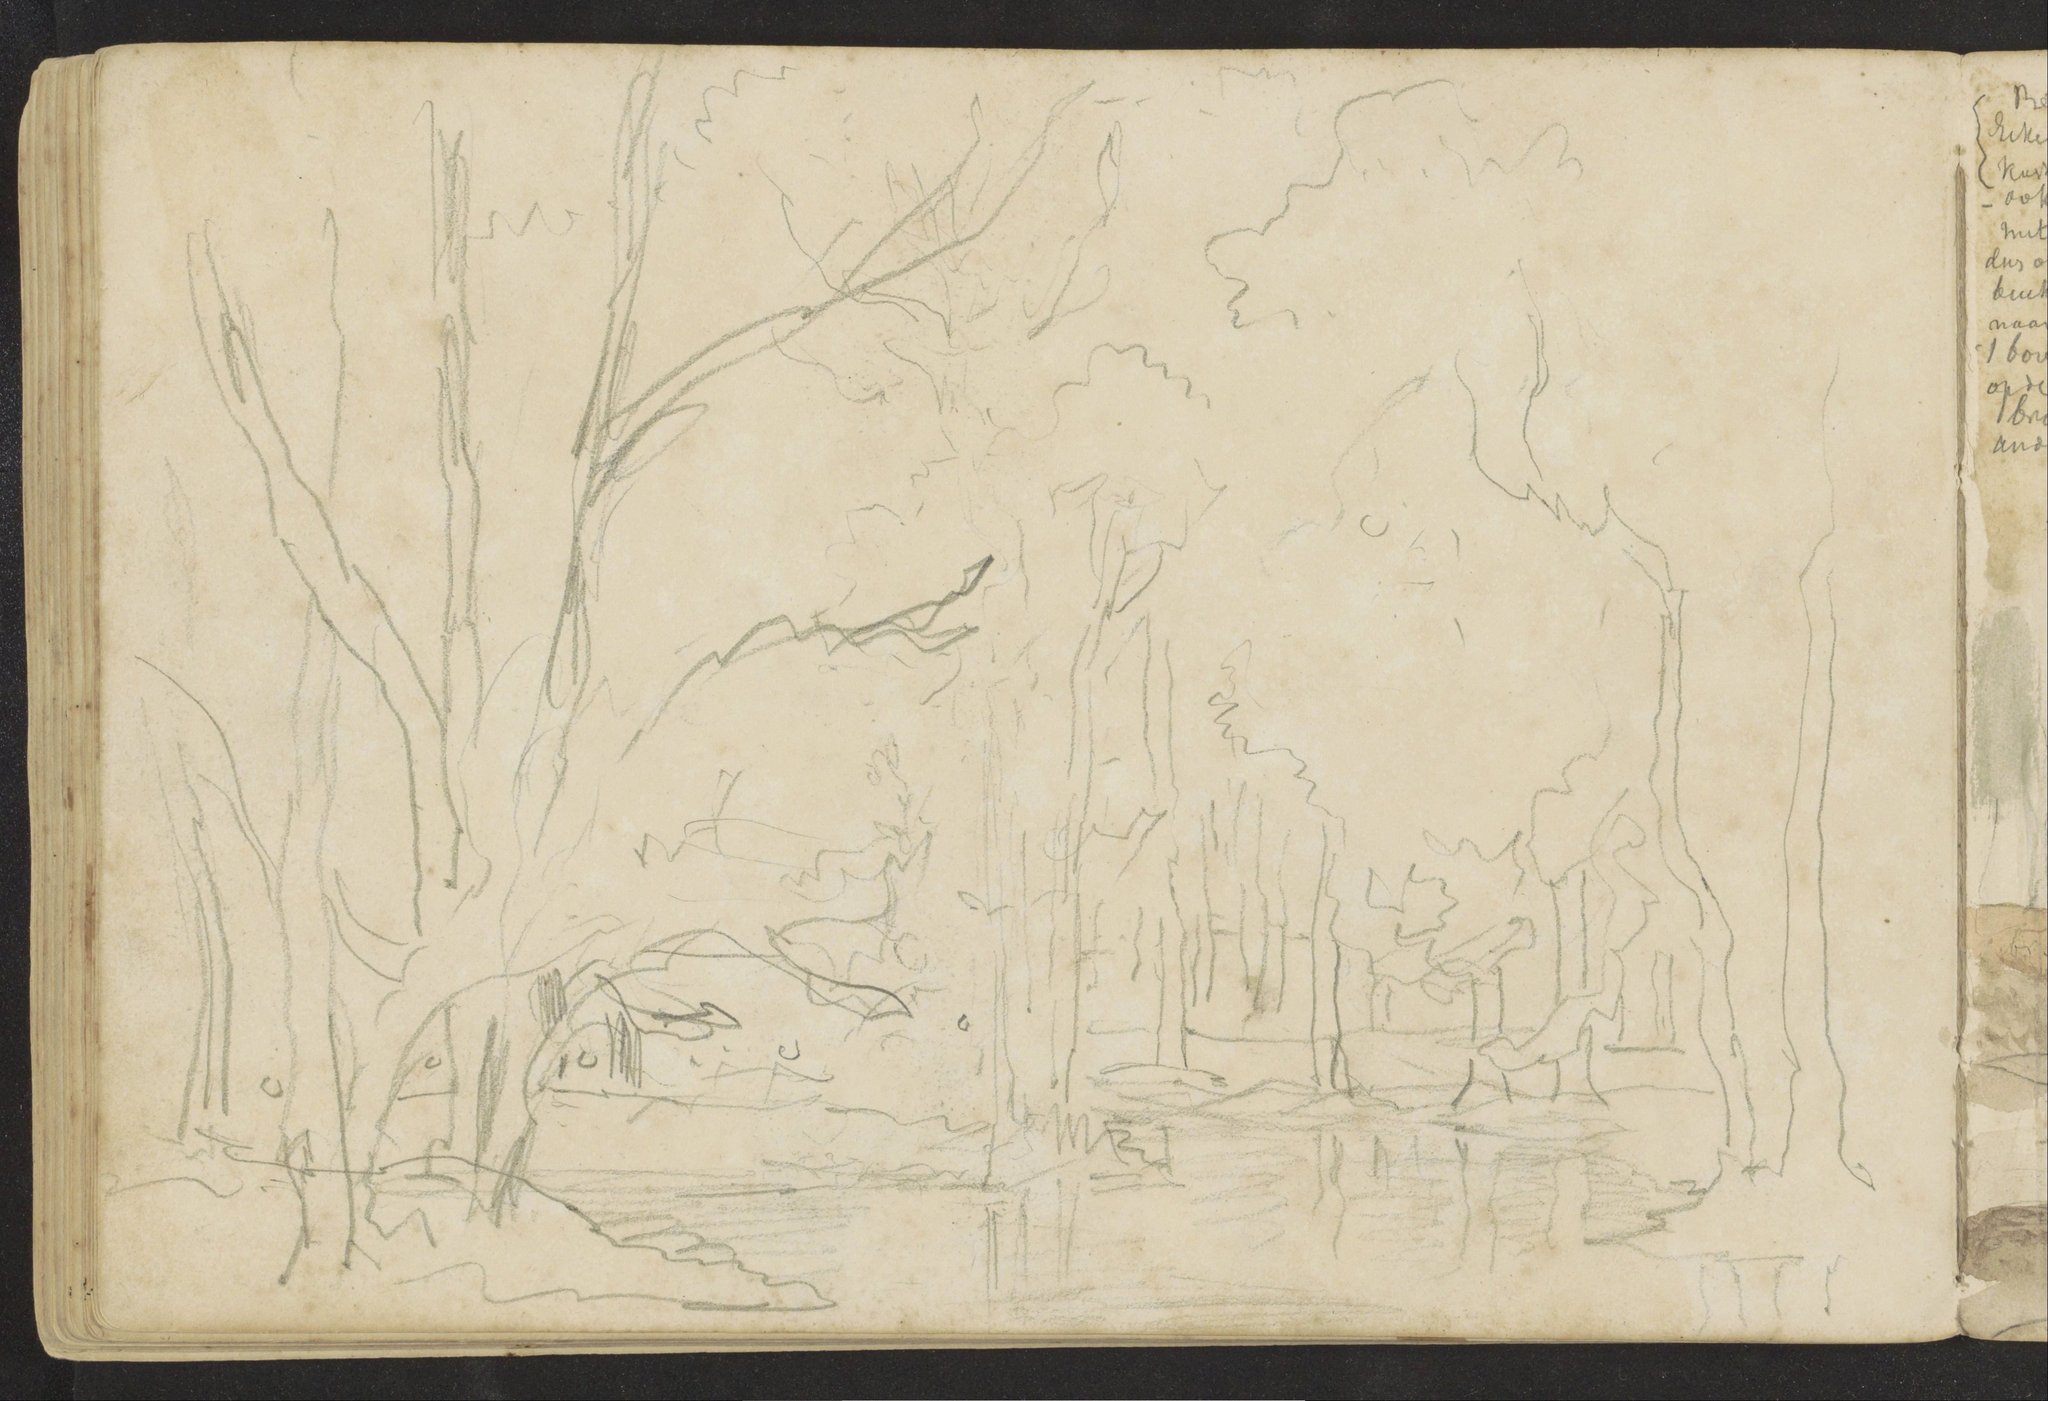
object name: sketchbook leaf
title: Waterpartij in het Haagse Bos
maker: johannes tavenraat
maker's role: draughtsman, painter, print maker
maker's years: 1809-1881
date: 1868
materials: paper, pencil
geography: the hague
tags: lake, forest, wood, the hague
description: Blad 42 verso in een schetsboek met 45 bladen.